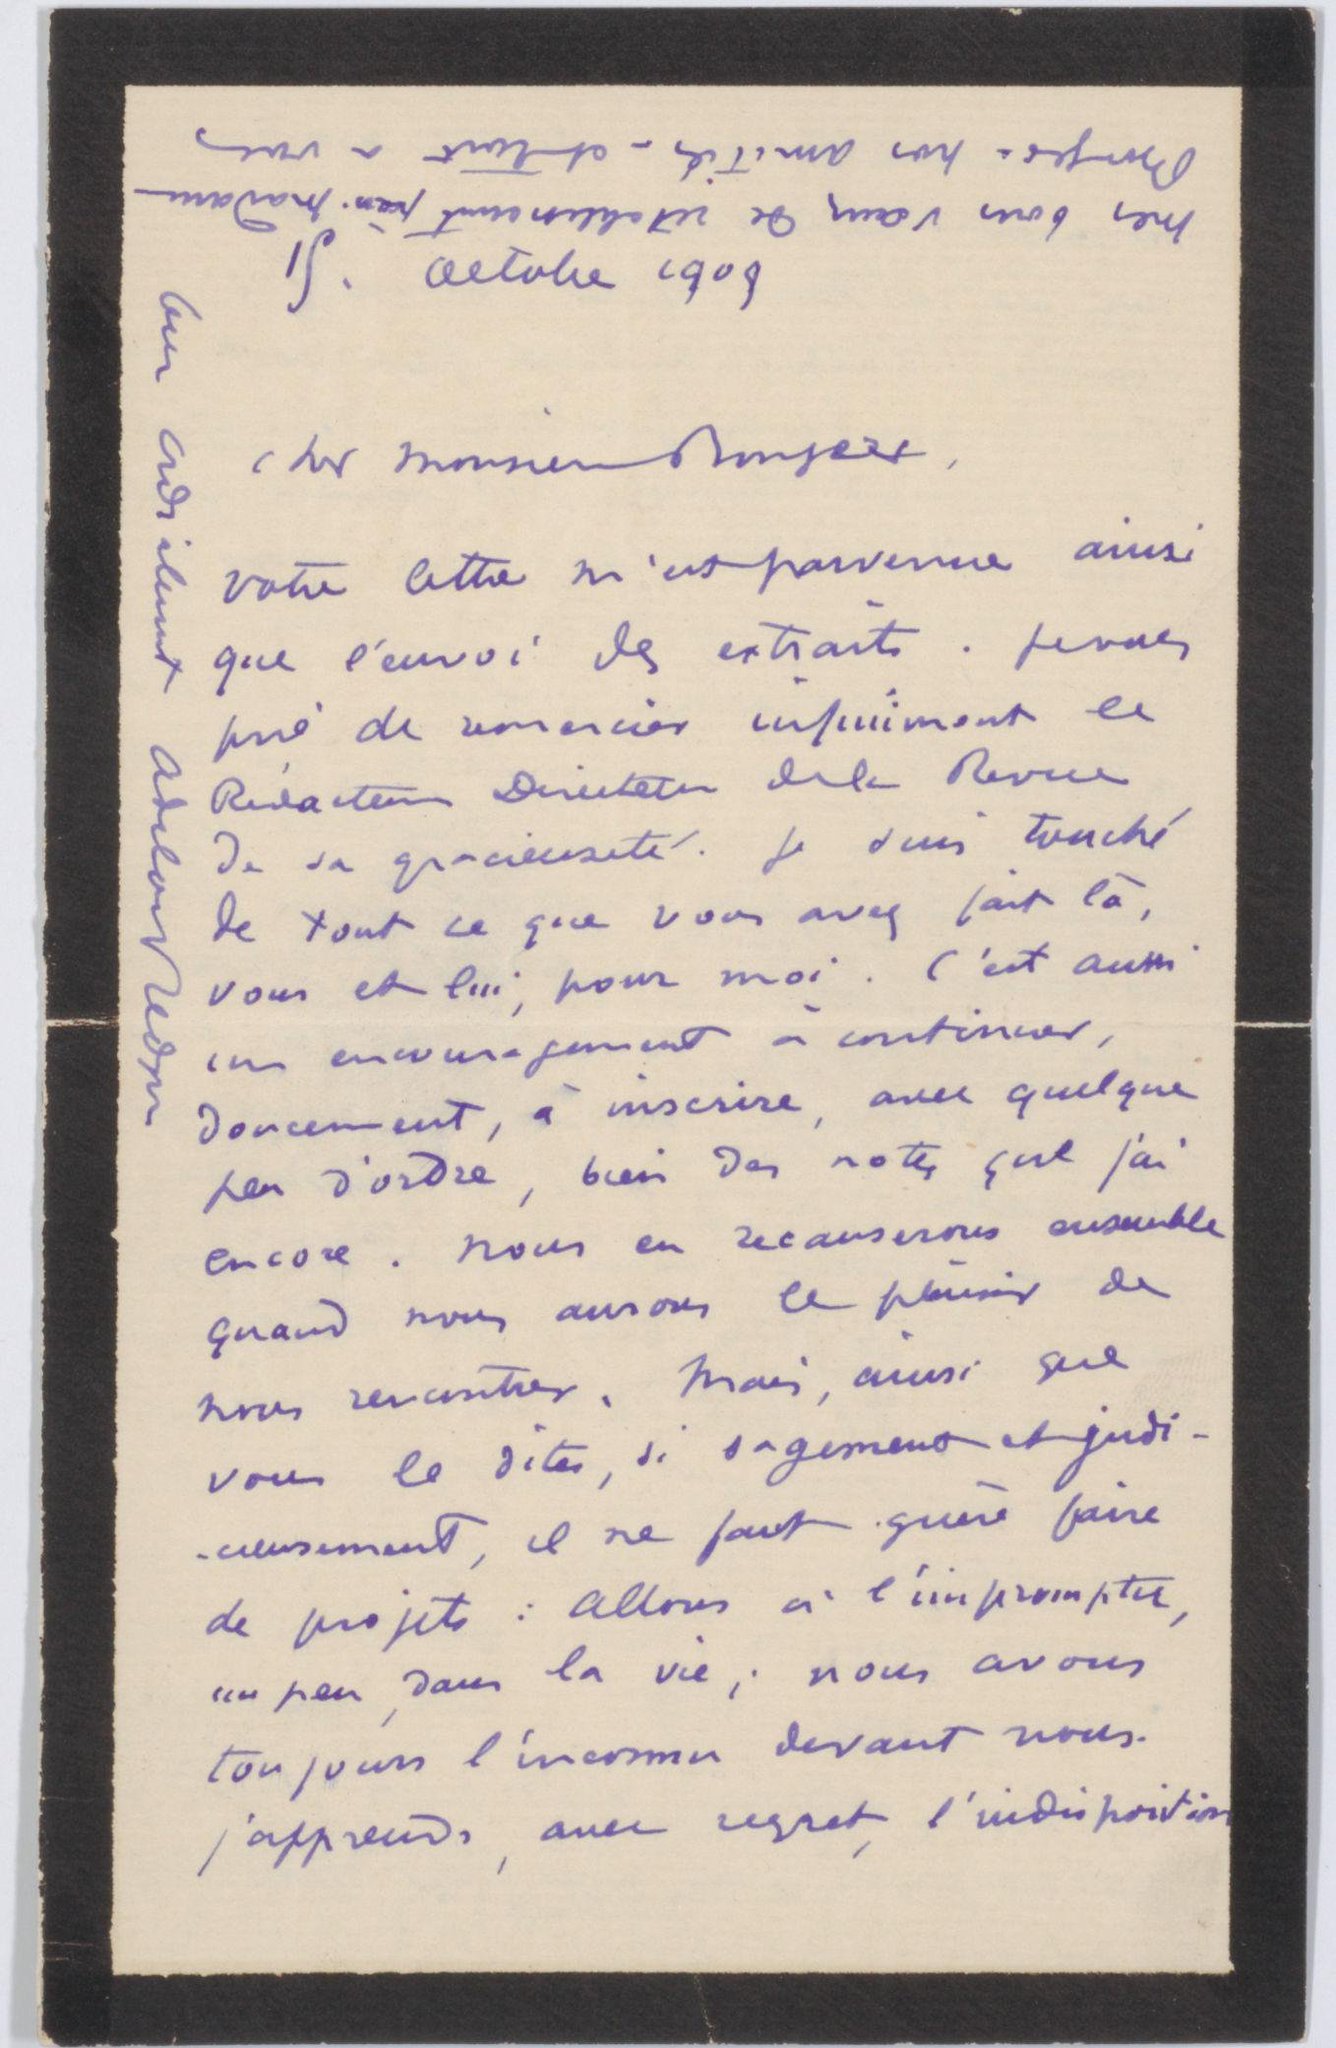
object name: letter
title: Brief aan Andries Bonger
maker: odilon redon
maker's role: draughtsman, painter, print maker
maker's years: 1840-1916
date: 1909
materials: ink, paper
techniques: pen, writing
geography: bièvres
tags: arï redon, paris, painter, print maker, draughtsman, camille corot, marseille, adolphe joseph thomas monticelli, andries bonger, family life, painting (including book-illumination, miniature-painting), diseases, printed matter